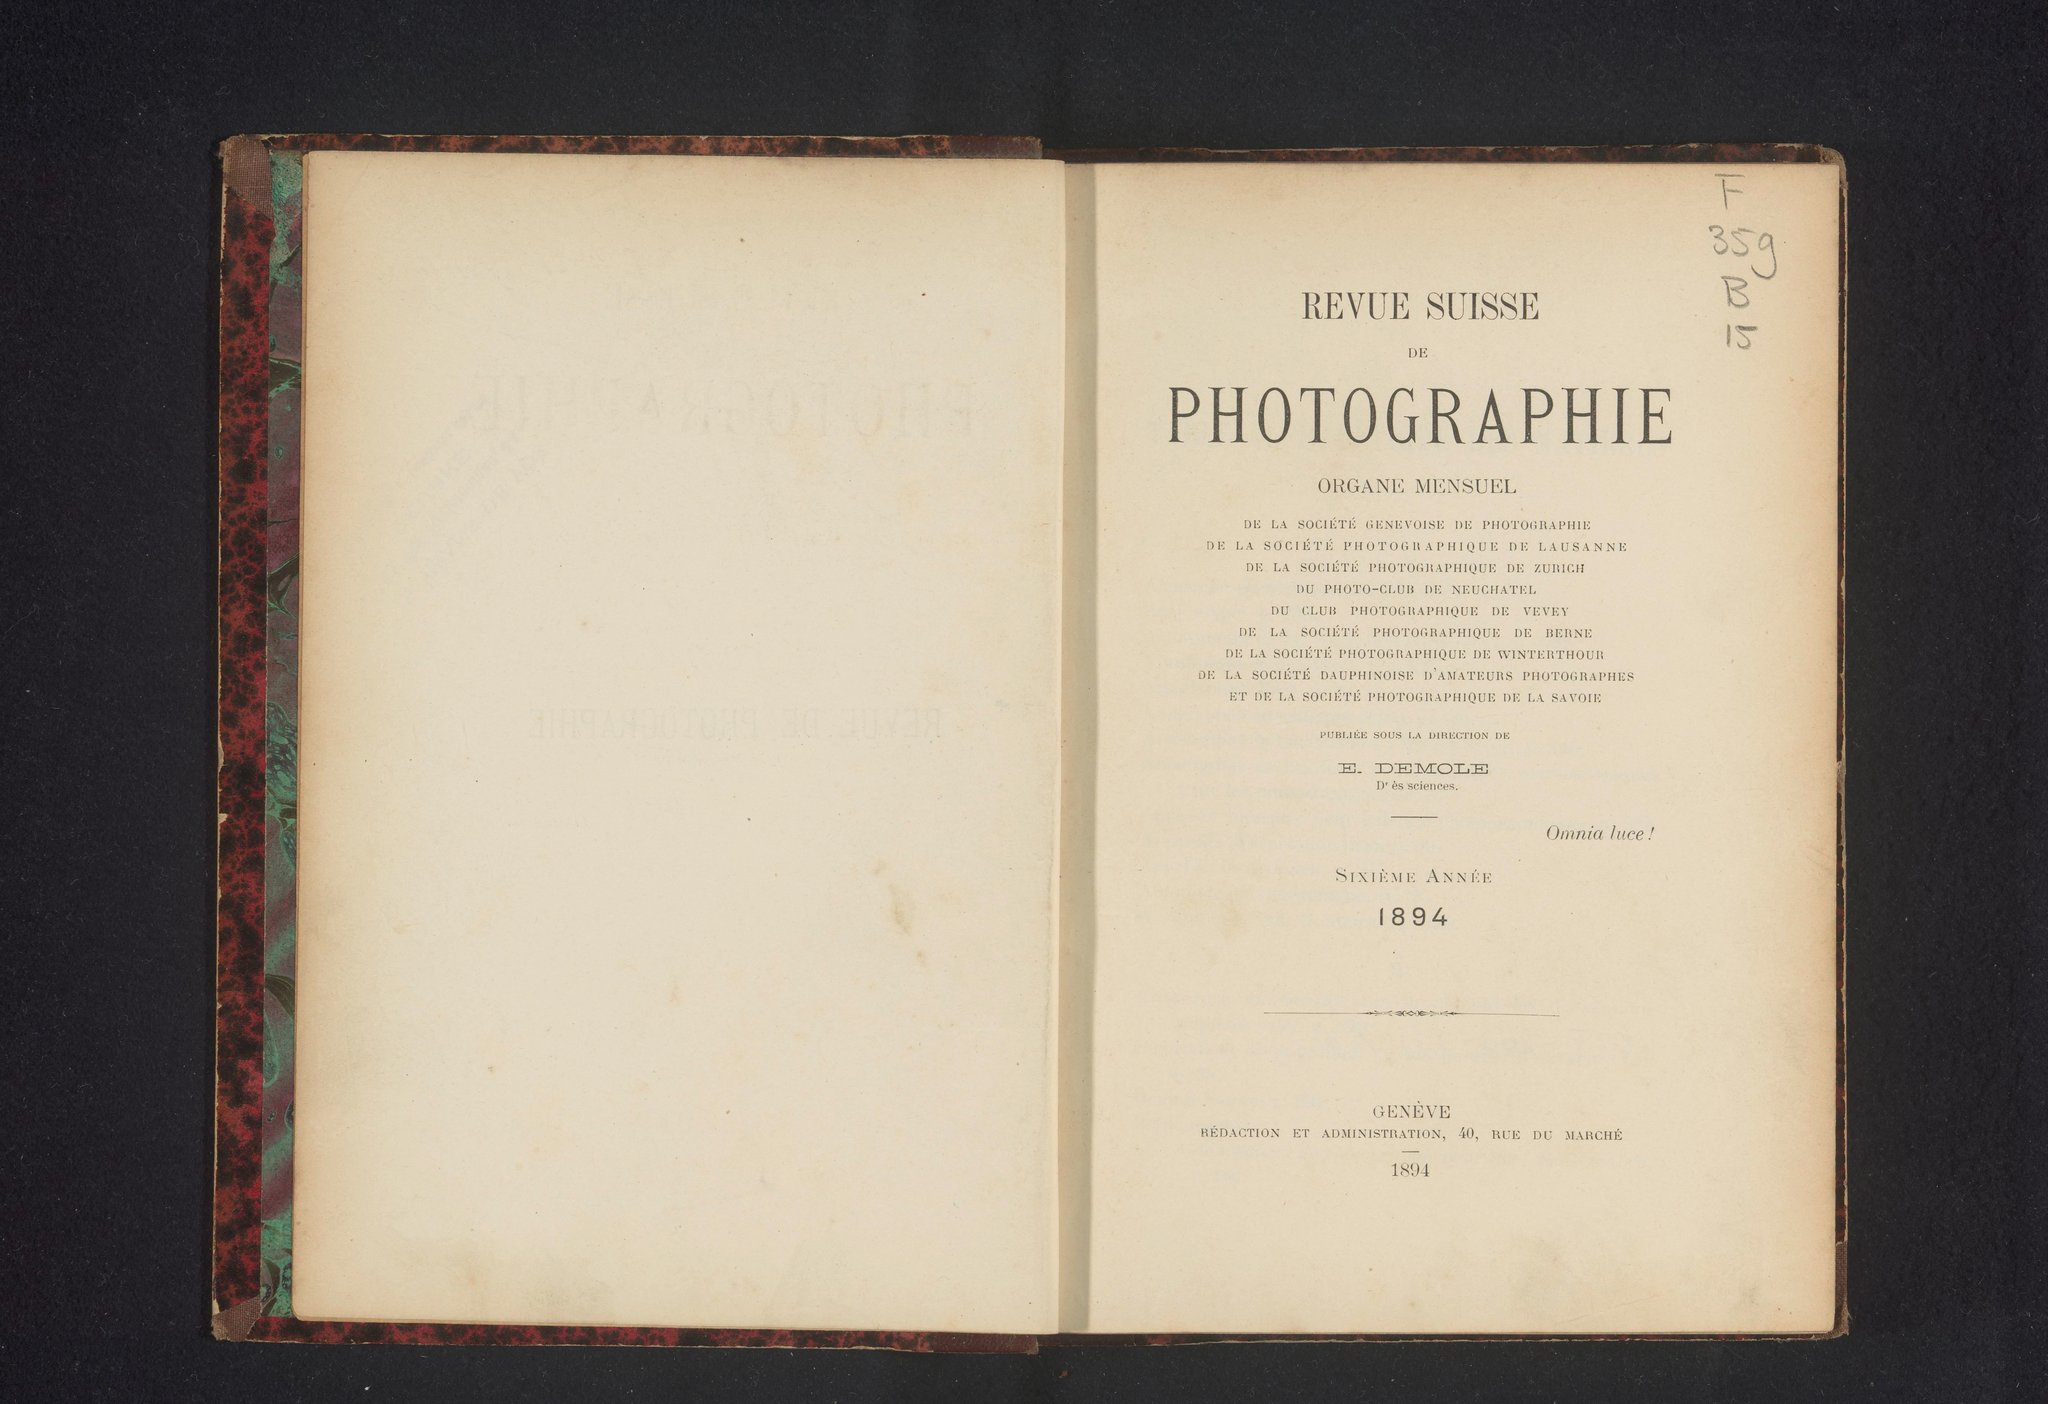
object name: book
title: Revue suisse de photographie / Société genevoise de photographie ... [et al.]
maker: eugène demole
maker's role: conservator, fotograaf, numismaat, scheikundige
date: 1894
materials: leather, paper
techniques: marbled paper, photograph, photoaquatint, printing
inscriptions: number: ‘243’, annotation: ‘Je. van Severen / Ruysselede’, collector's mark: ‘Dr. Frans de vos/ 64 tot Rivierenlaan, 64/ Deurne/ [...]’, date: ‘Nov 1994’